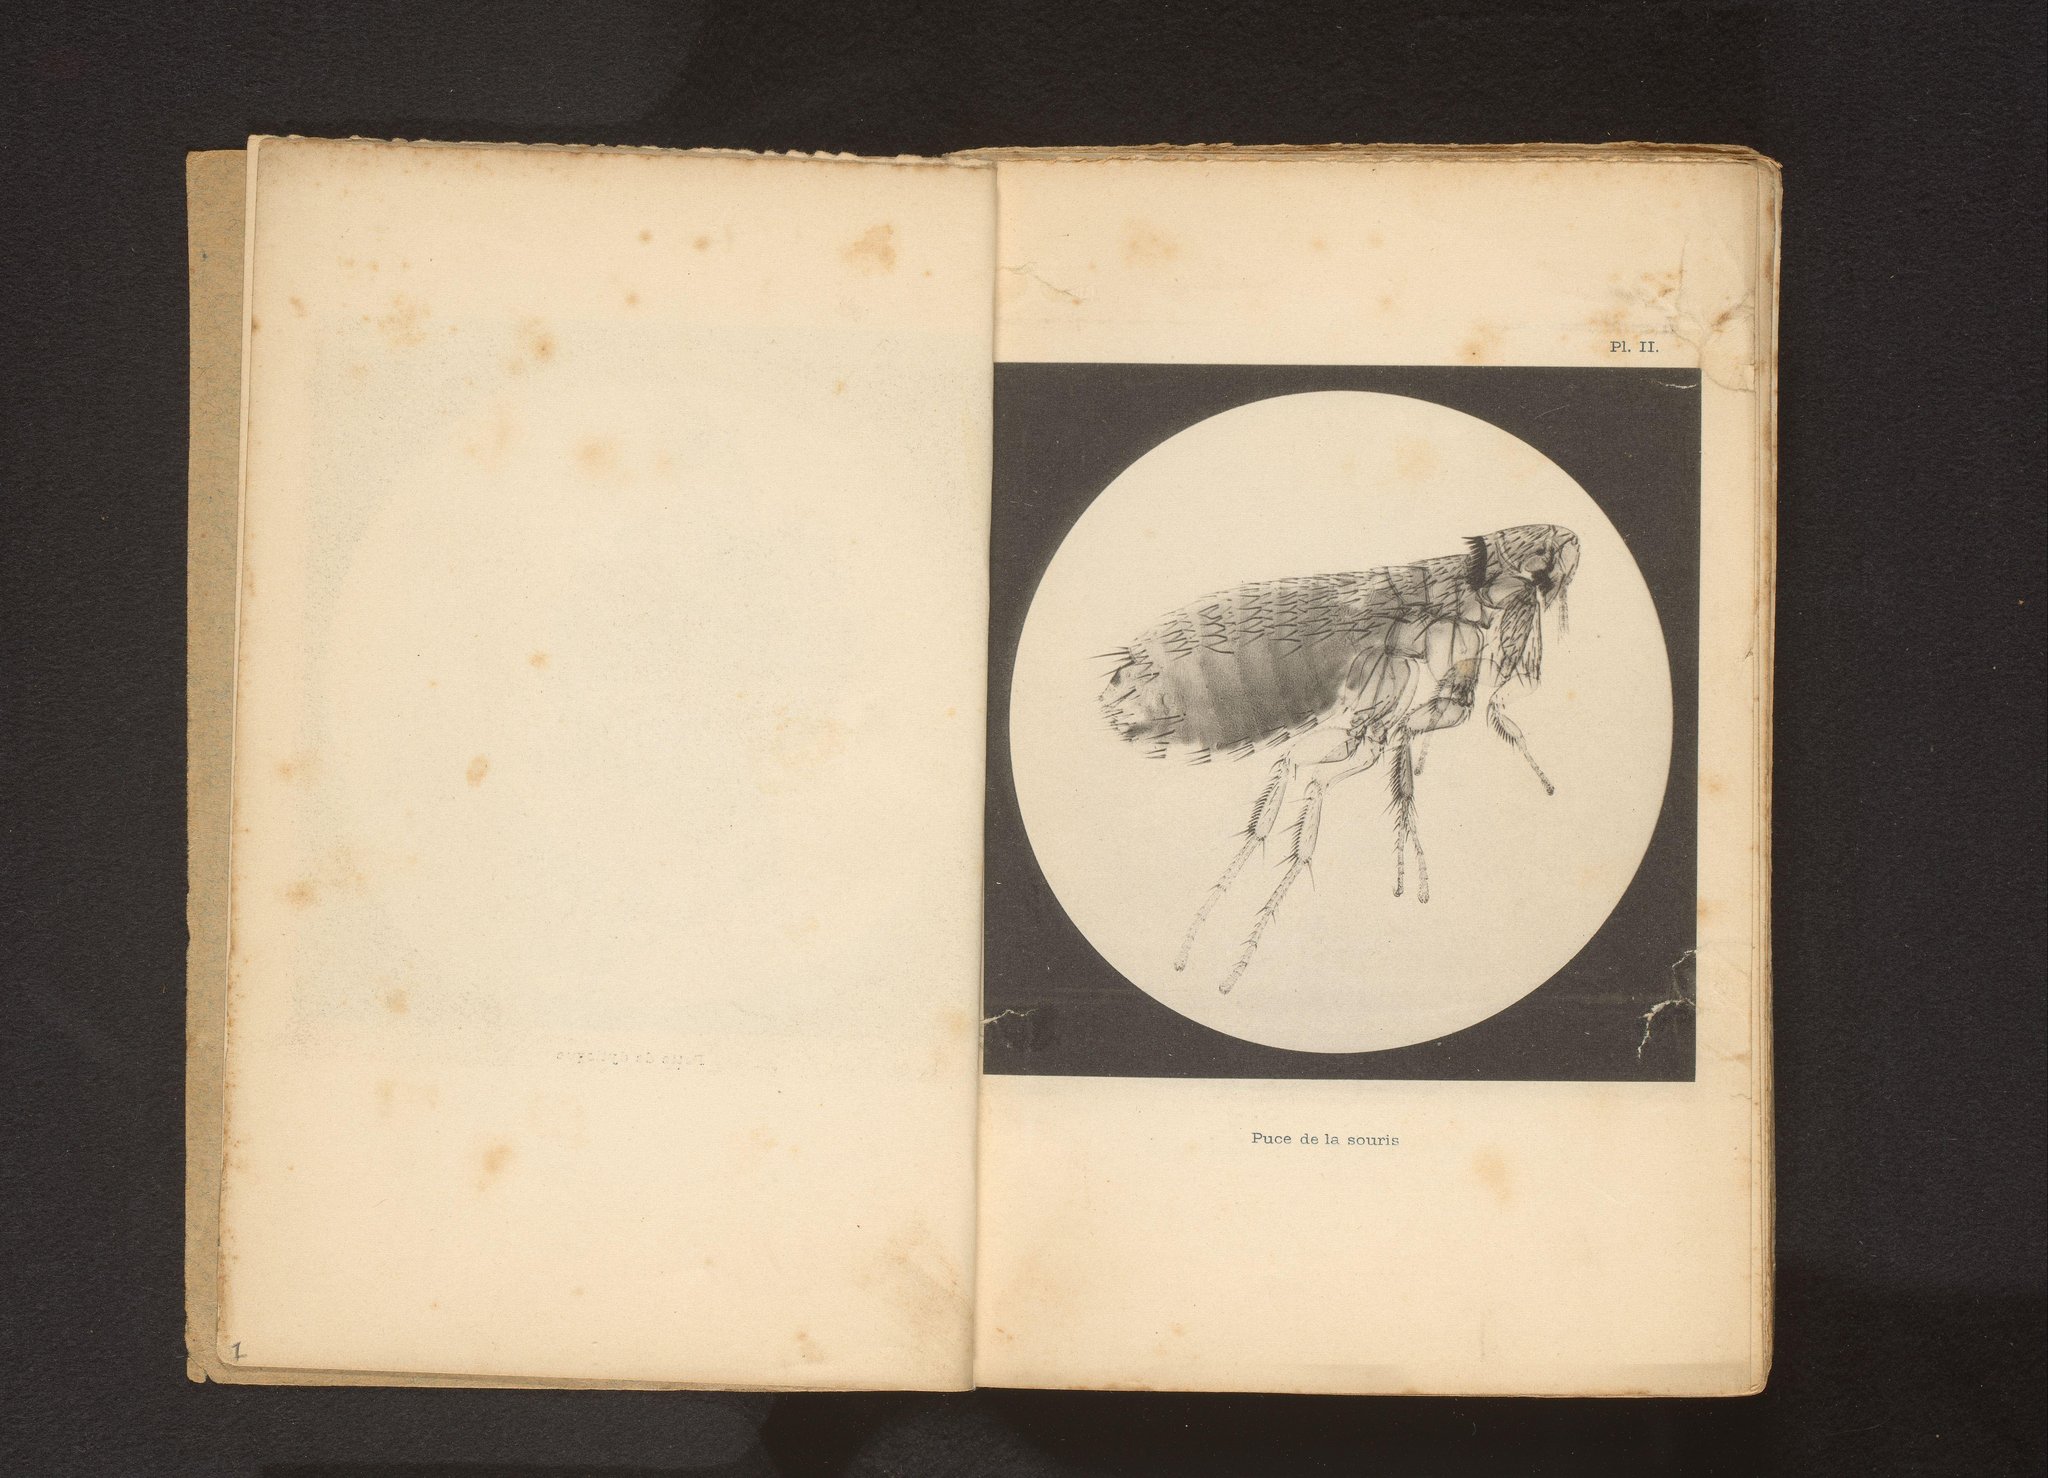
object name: photomechanical print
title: Microscoopopname van een vlo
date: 1880-1899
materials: paper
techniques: photograph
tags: insects: flea, microscope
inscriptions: number: ‘Pl. II.’